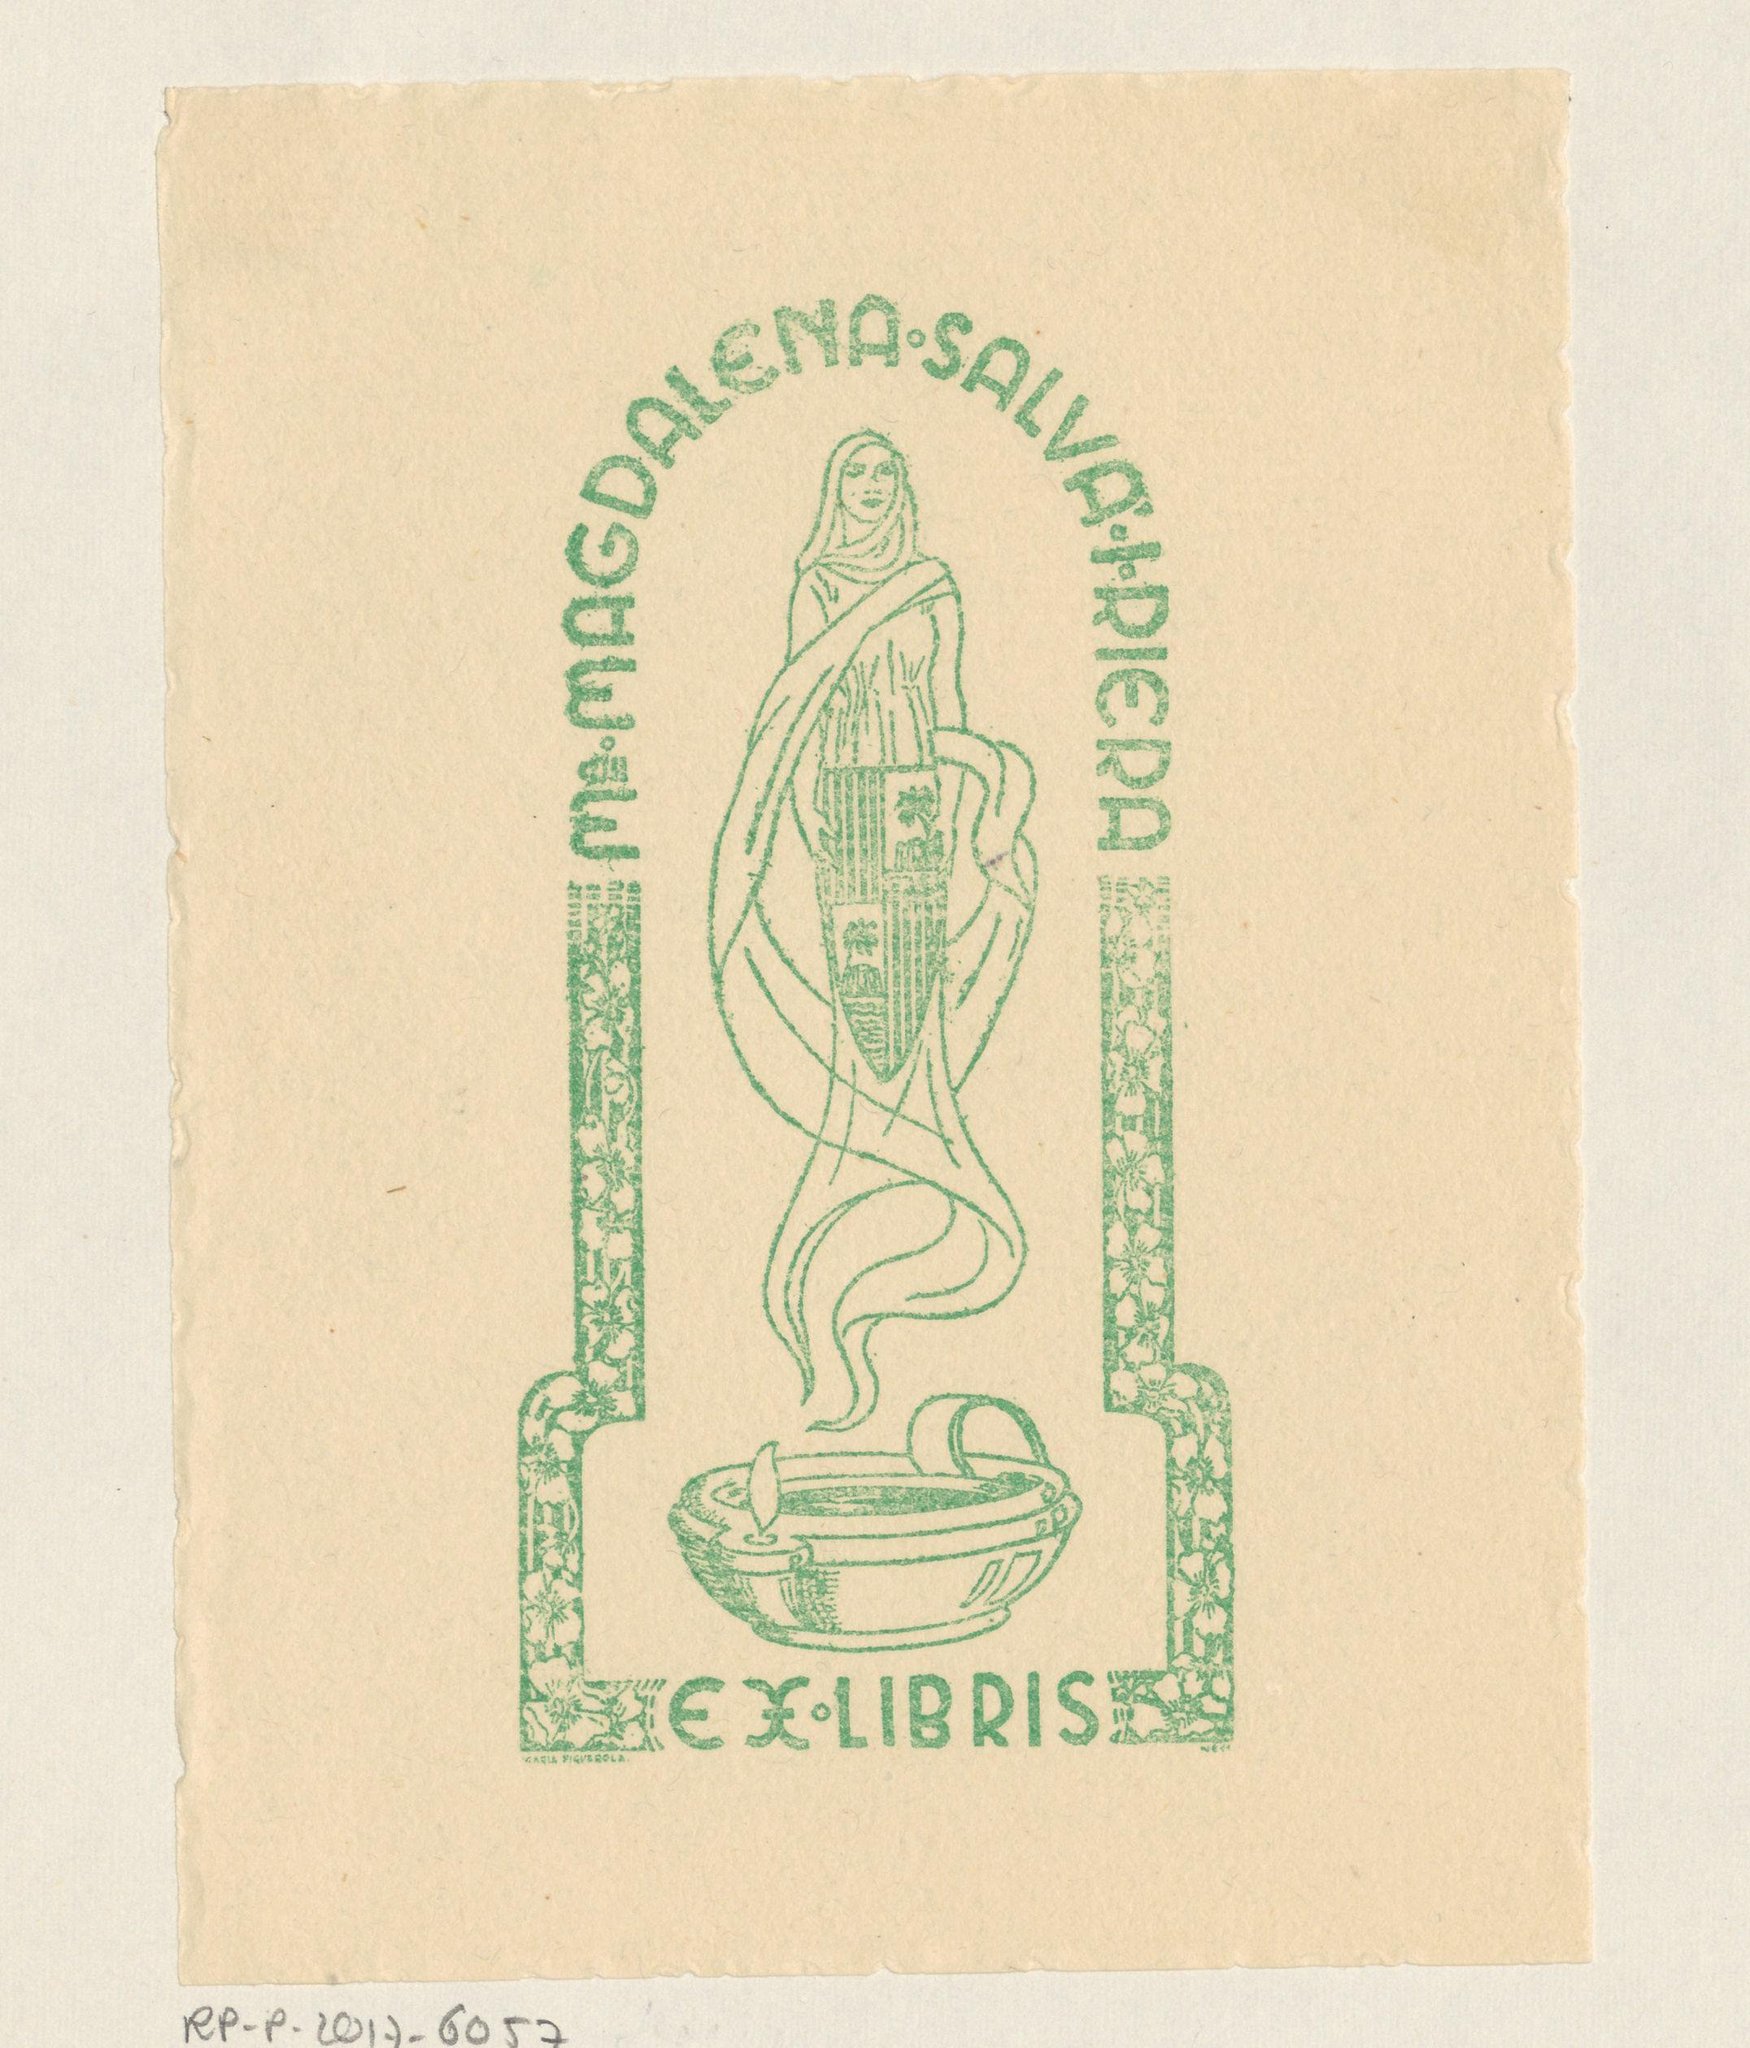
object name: bookplate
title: Ex libris van Magdalena Salvá i Riera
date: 1888-1946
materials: paper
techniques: printing block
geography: spain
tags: oil-lamp, armorial bearing, heraldry